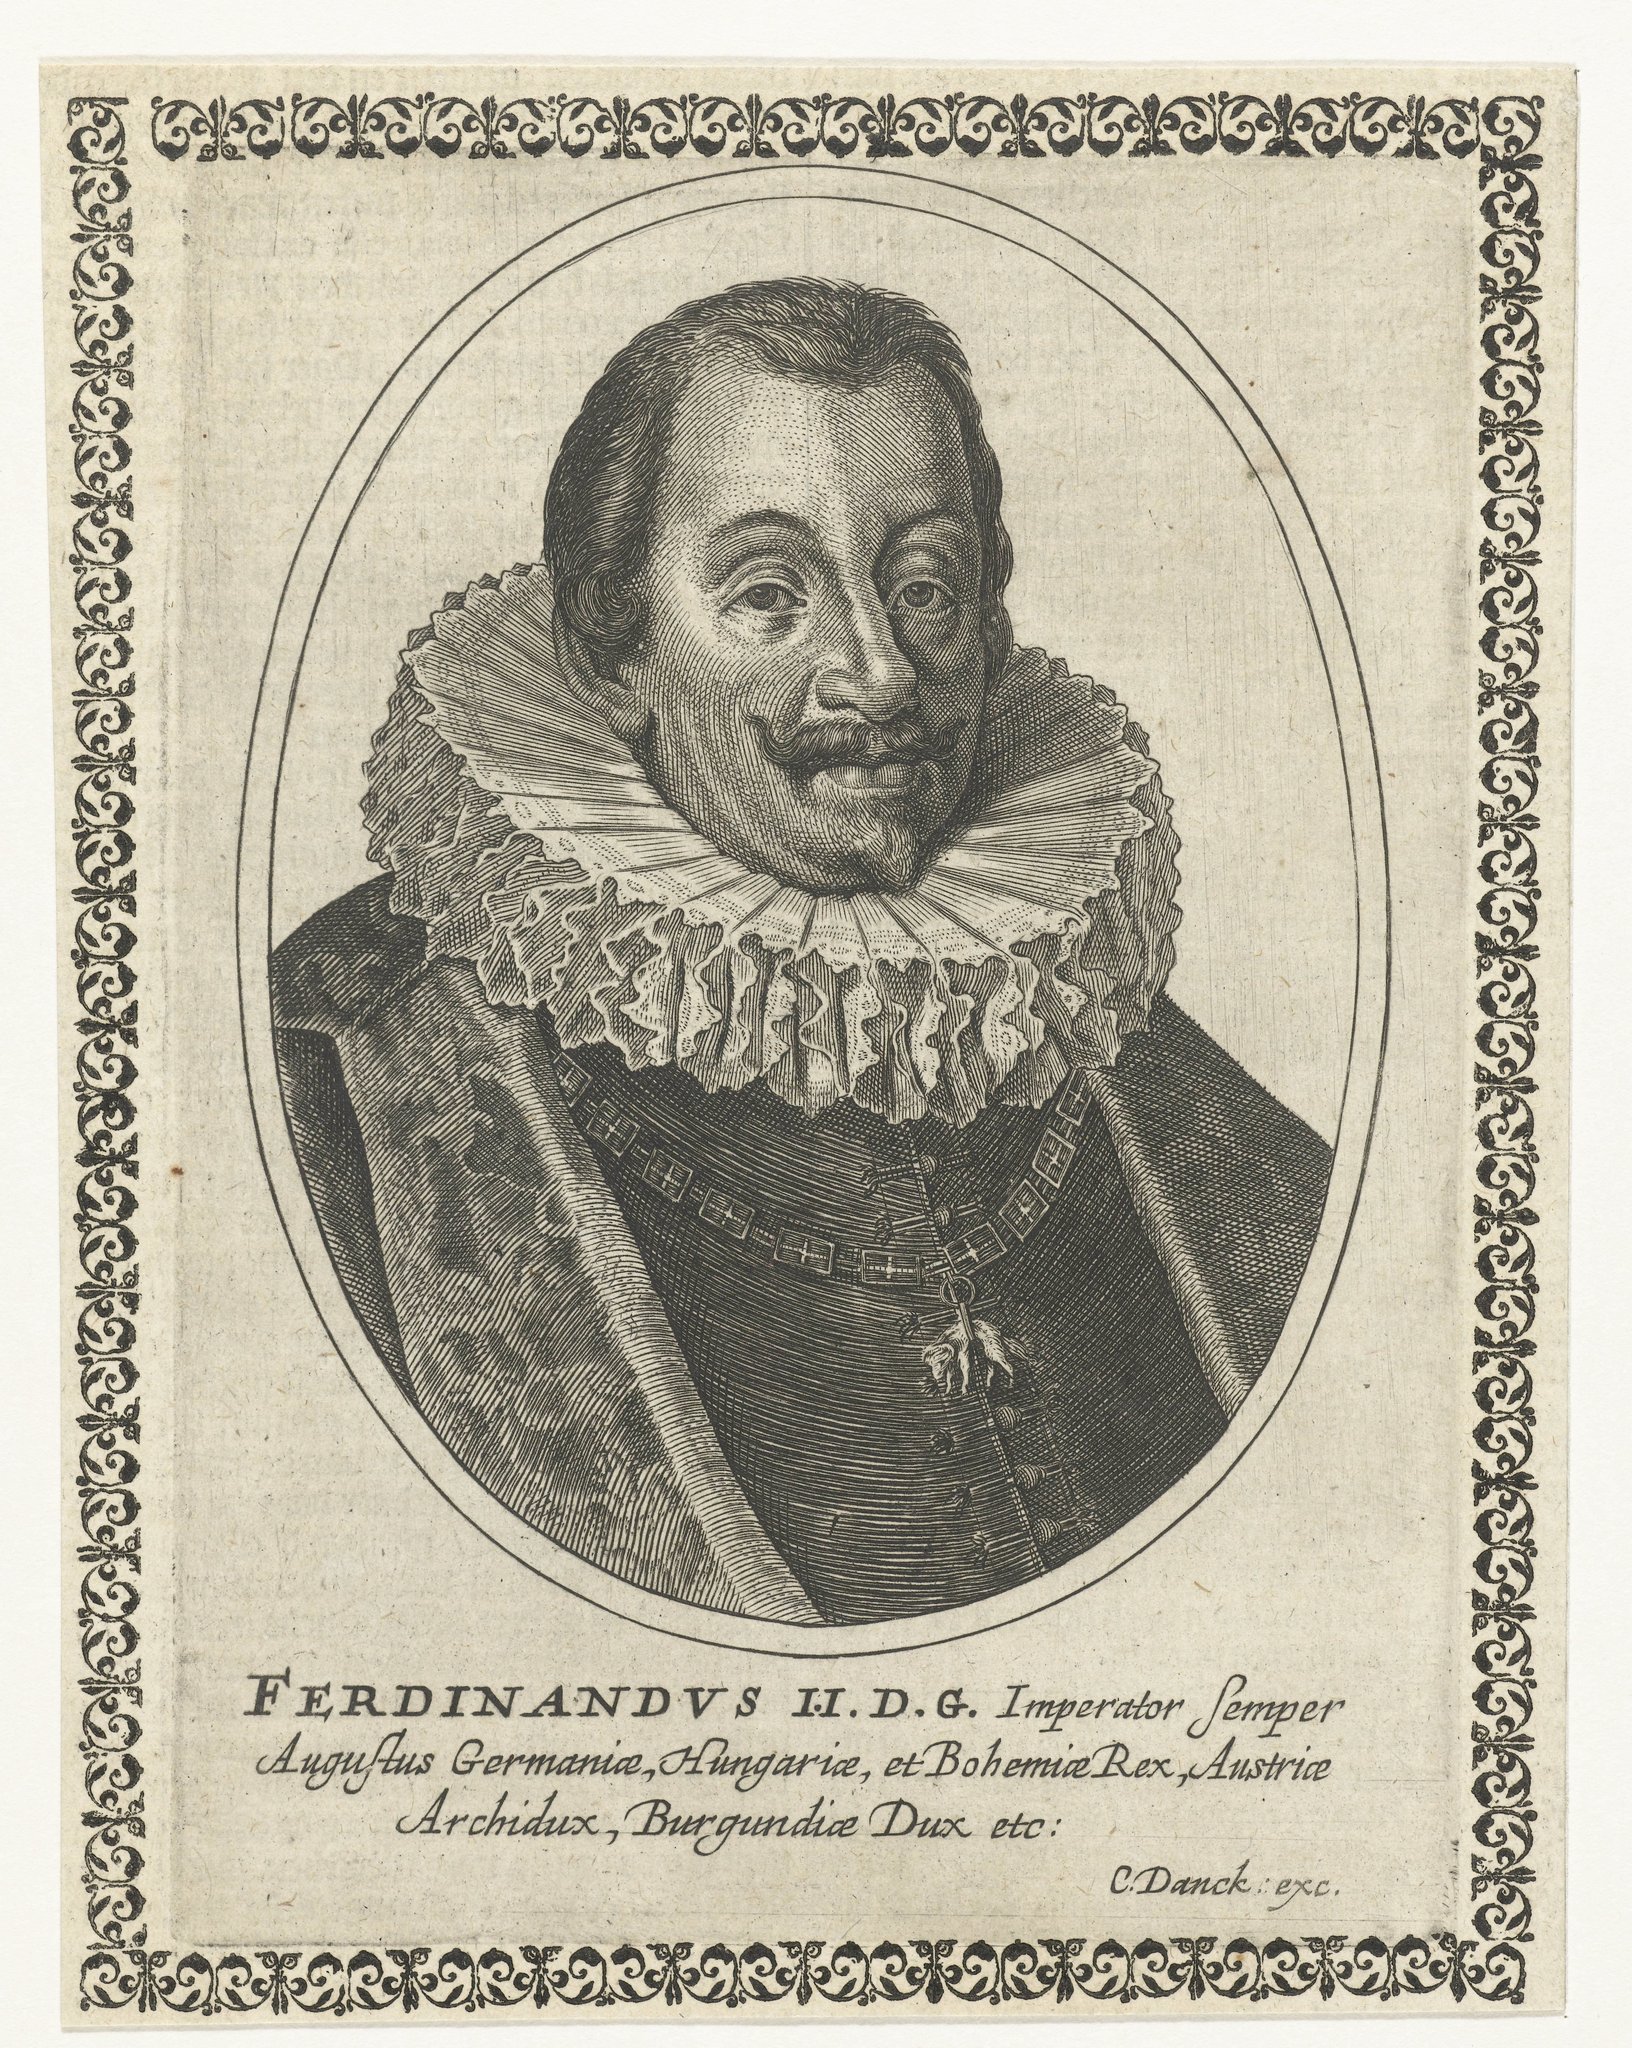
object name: book illustration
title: Portret van Ferdinand II in ovaal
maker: cornelis danckerts (i)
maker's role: print maker, publisher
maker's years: 1604-1656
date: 1613-1656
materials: paper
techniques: engraving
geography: netherlands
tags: vienna, ferdinand ii (duits keizer)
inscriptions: collector's mark: Lugt 2228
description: Portret van Ferdinand II, Duits keizer, Borststuk in ovaal met molenkraag. In rechthoekige ornamentrand gedrukt met andere plaat. Op verso Nederlandse tekst in boekdruk.